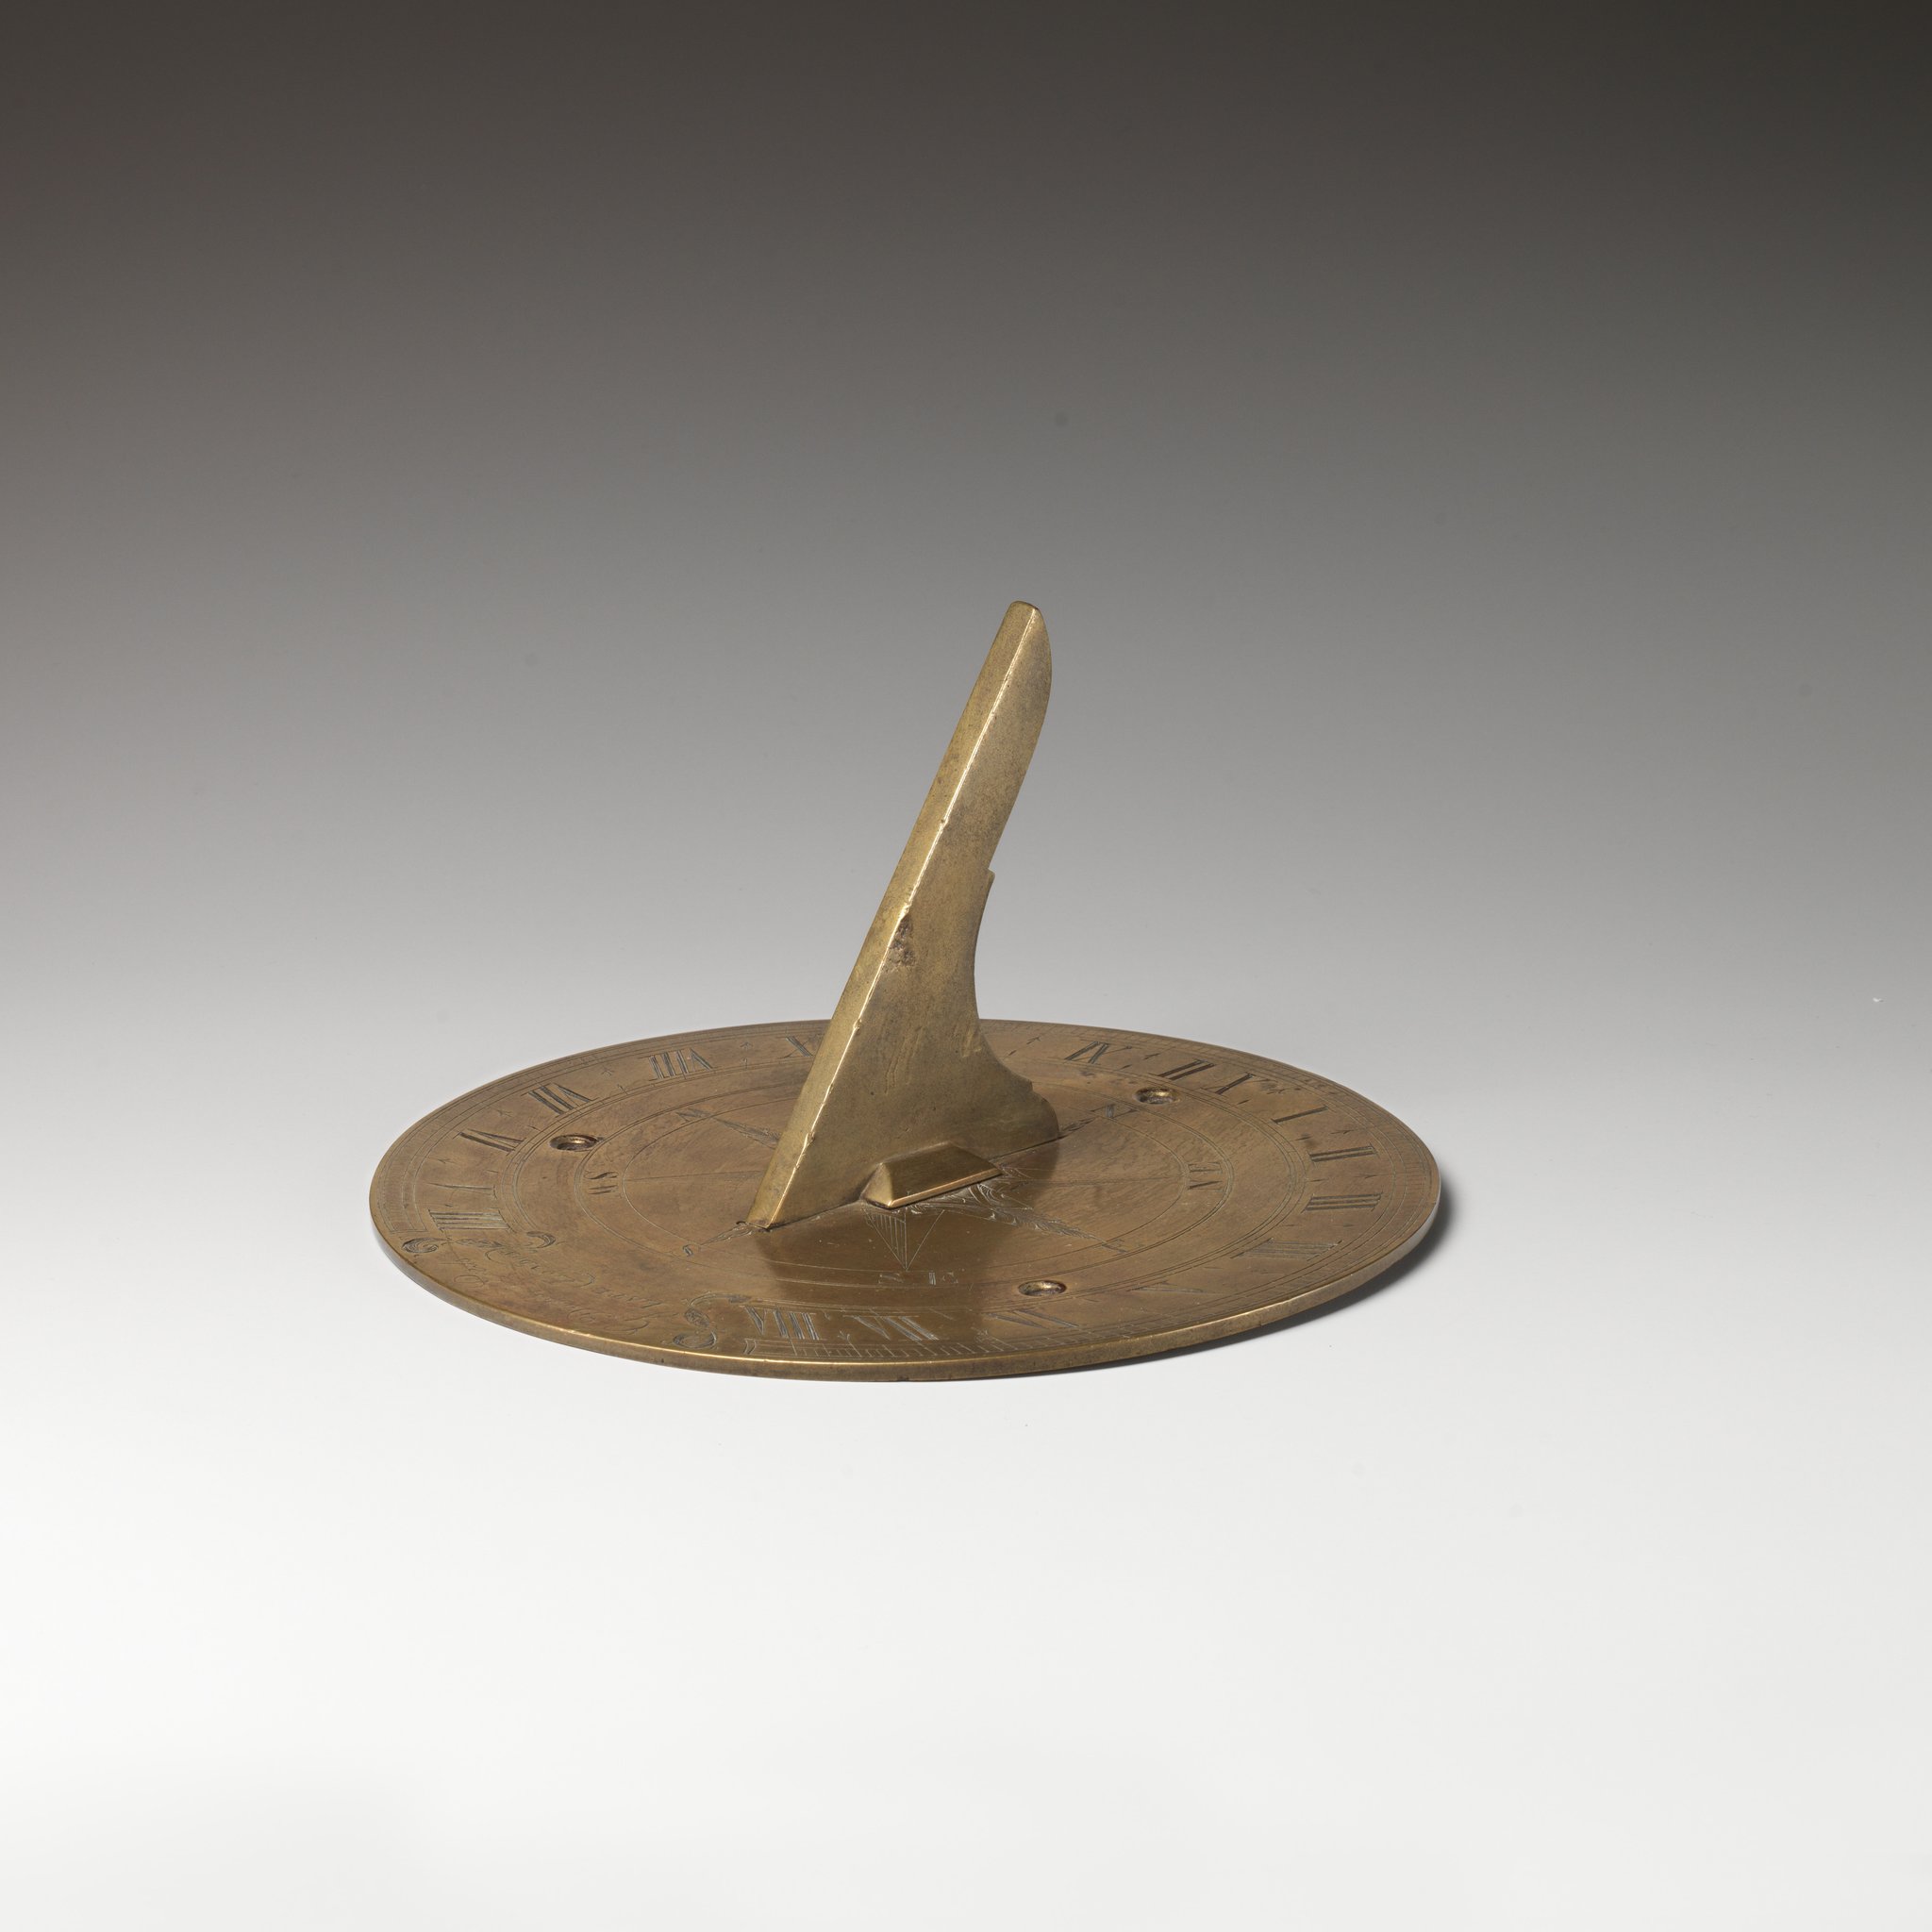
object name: stationary horizontal sundial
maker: george (?) davis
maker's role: maker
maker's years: 1690-1750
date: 1720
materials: brass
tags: sundials